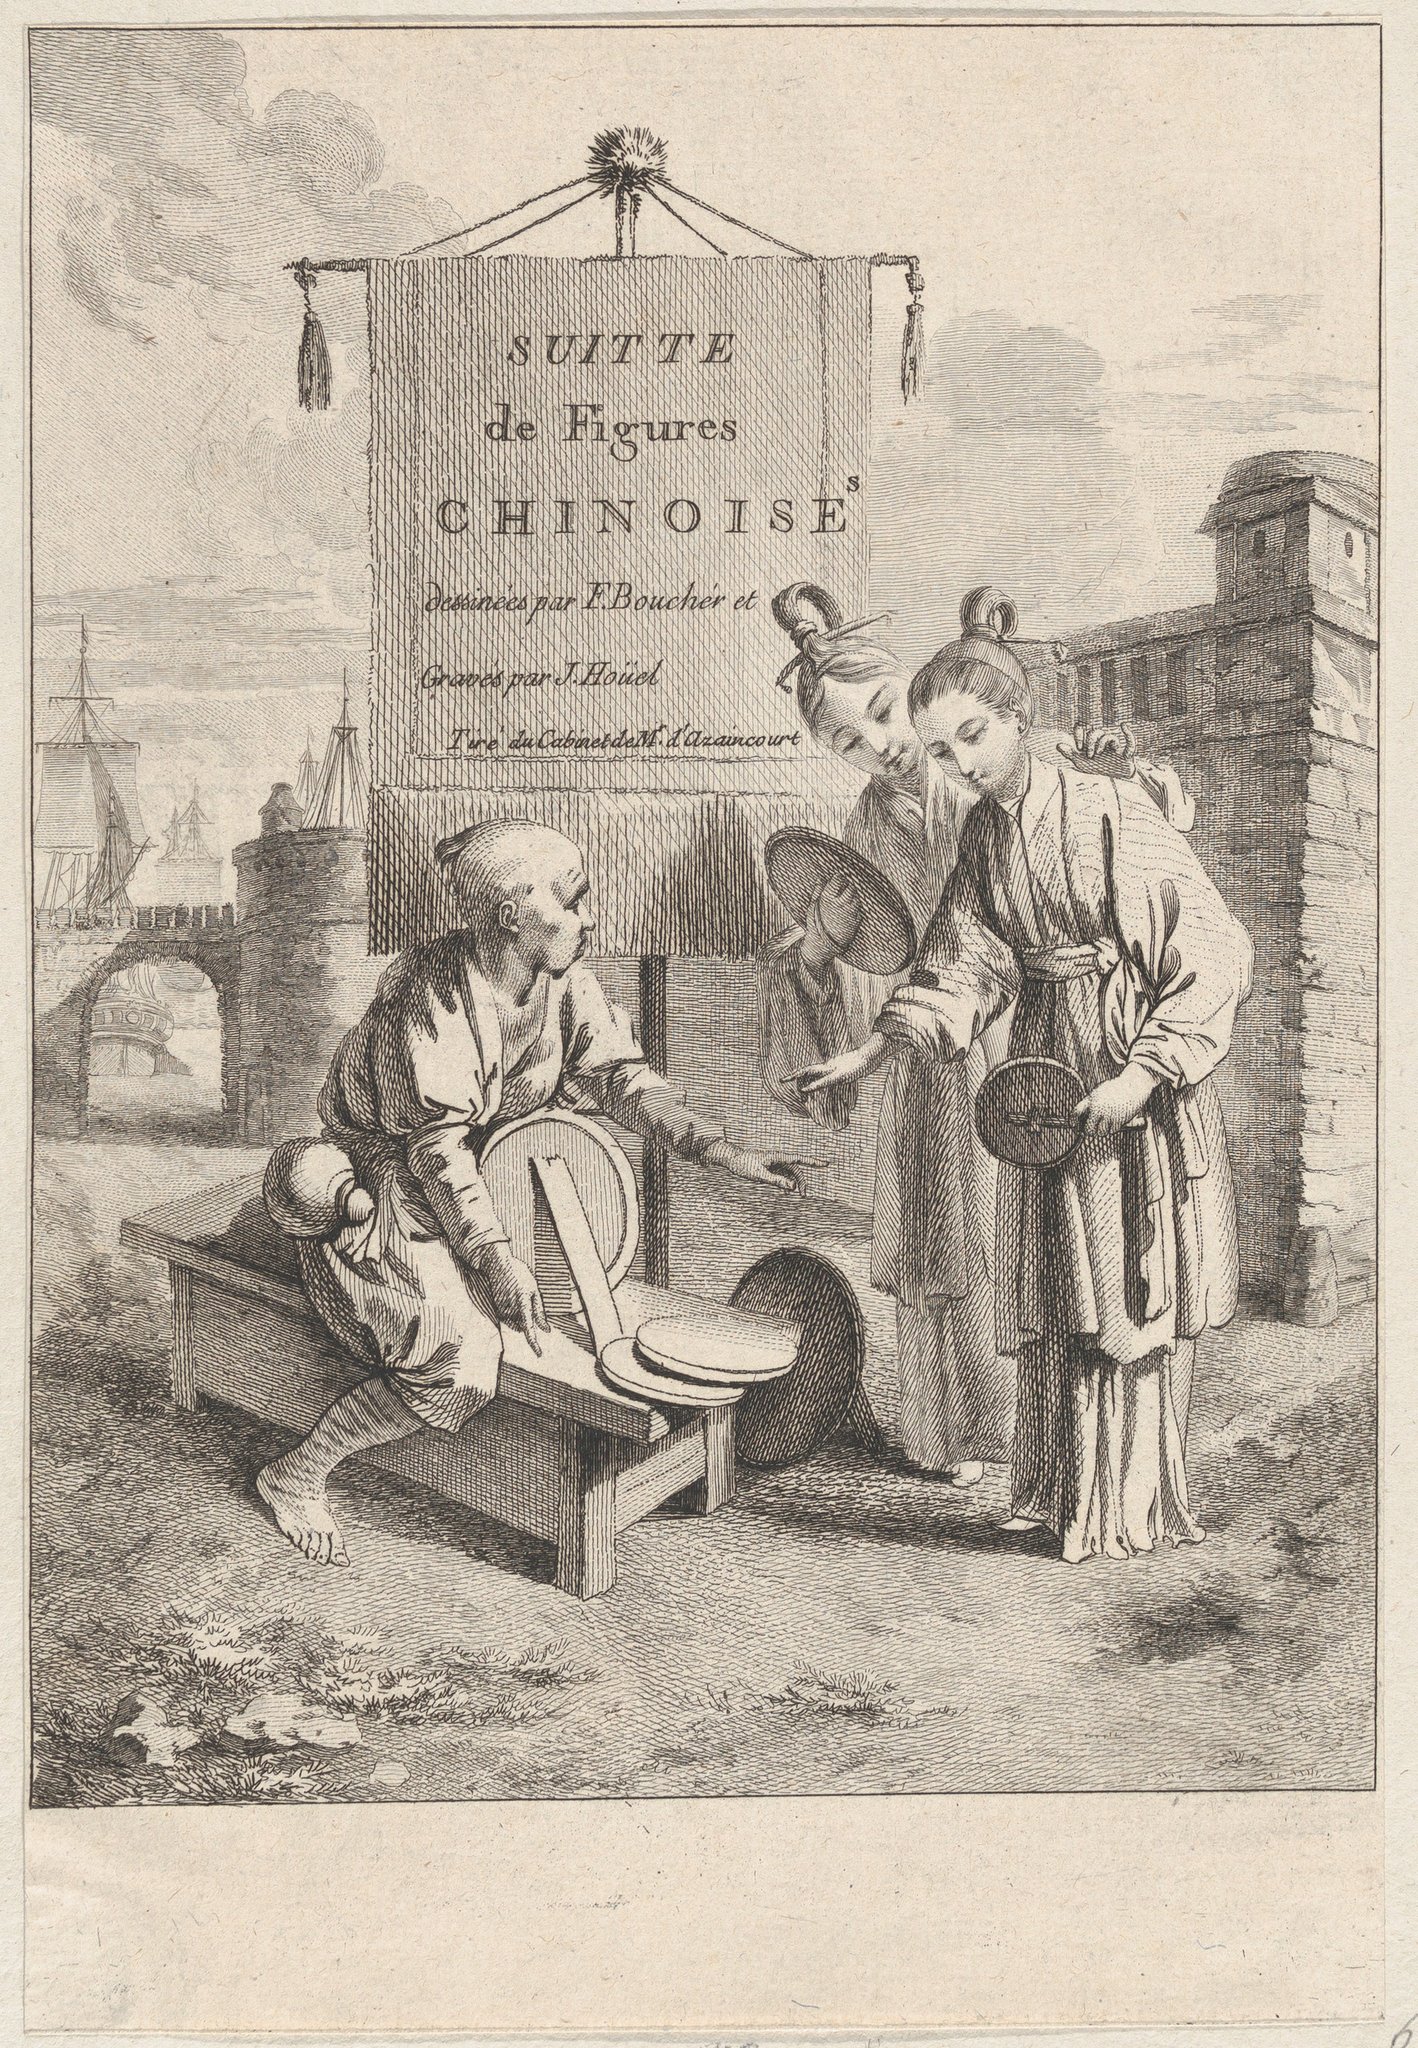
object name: print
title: Frontispiece, from Suite de Figures Chinoises. . . Tiré du Cabinet de Mr. d'Azaincourt (Series of Chinoiserie Figures. . .From the Chambers of Mr. d'Azaincourt)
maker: jean pierre louis laurent hoüel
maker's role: artist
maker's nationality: french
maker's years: 1735-1813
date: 1755-1776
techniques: engraving, etching